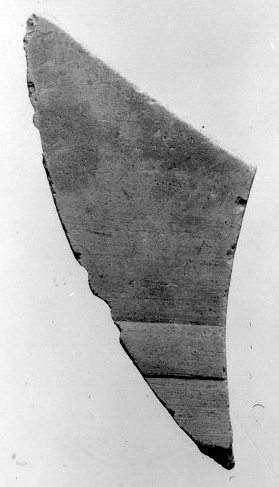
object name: relief fragment, tomb of meketre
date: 1981-1975 BCE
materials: limestone, paint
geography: egypt